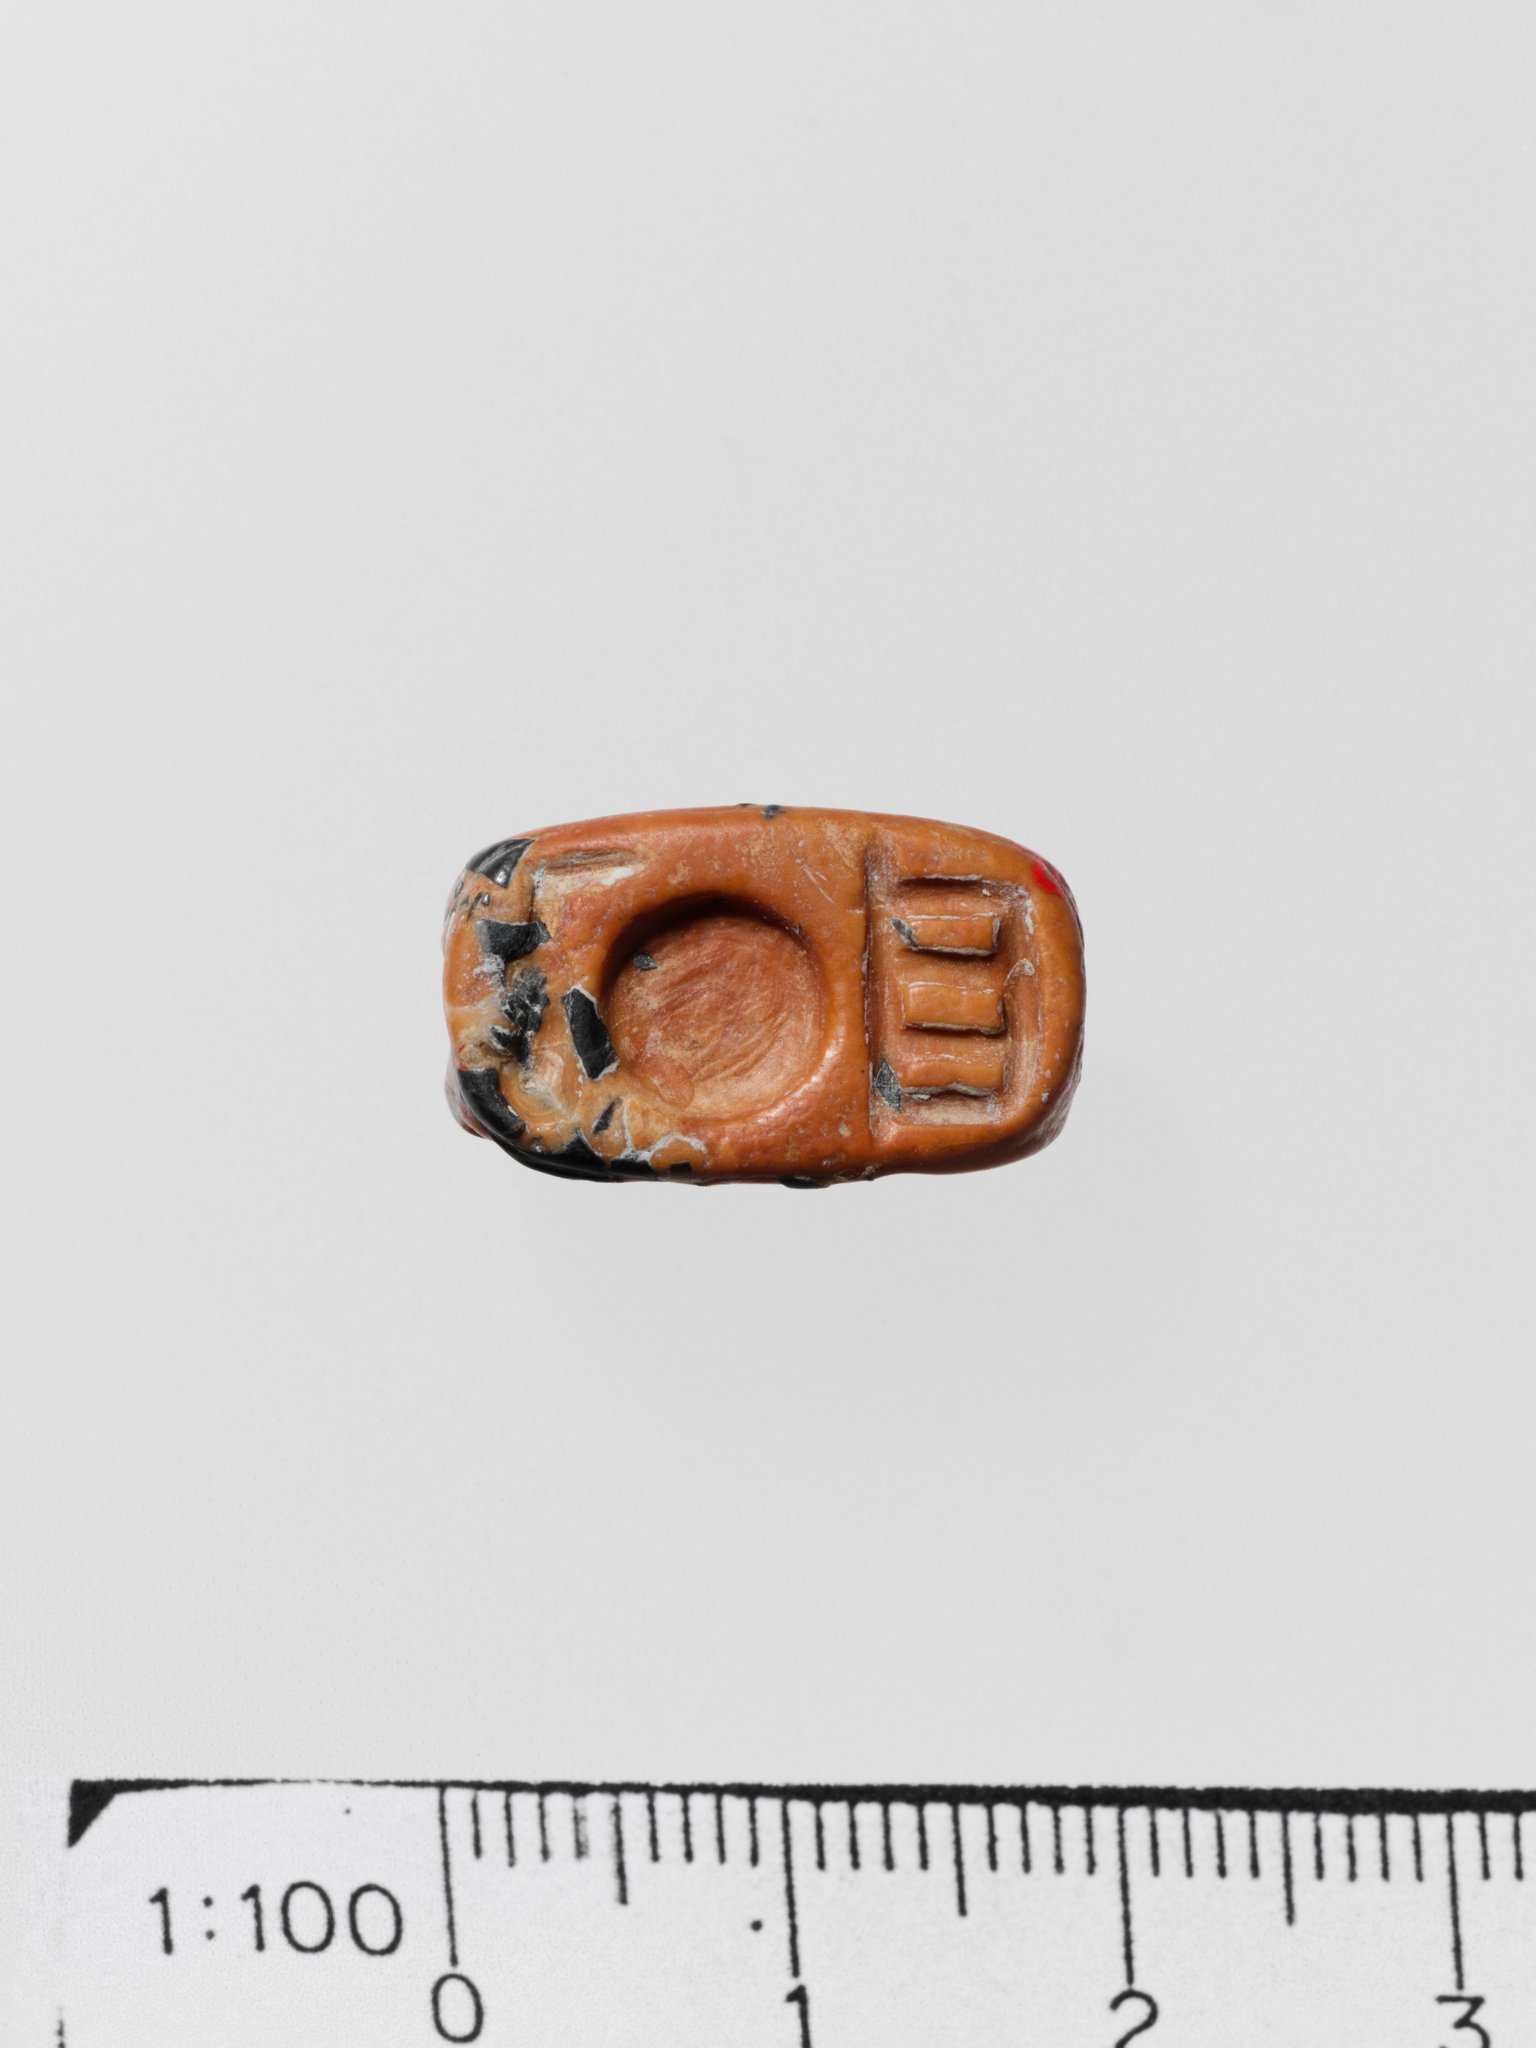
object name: seal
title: Jasper triangular prism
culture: minoan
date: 1900-1750 BCE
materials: jasper